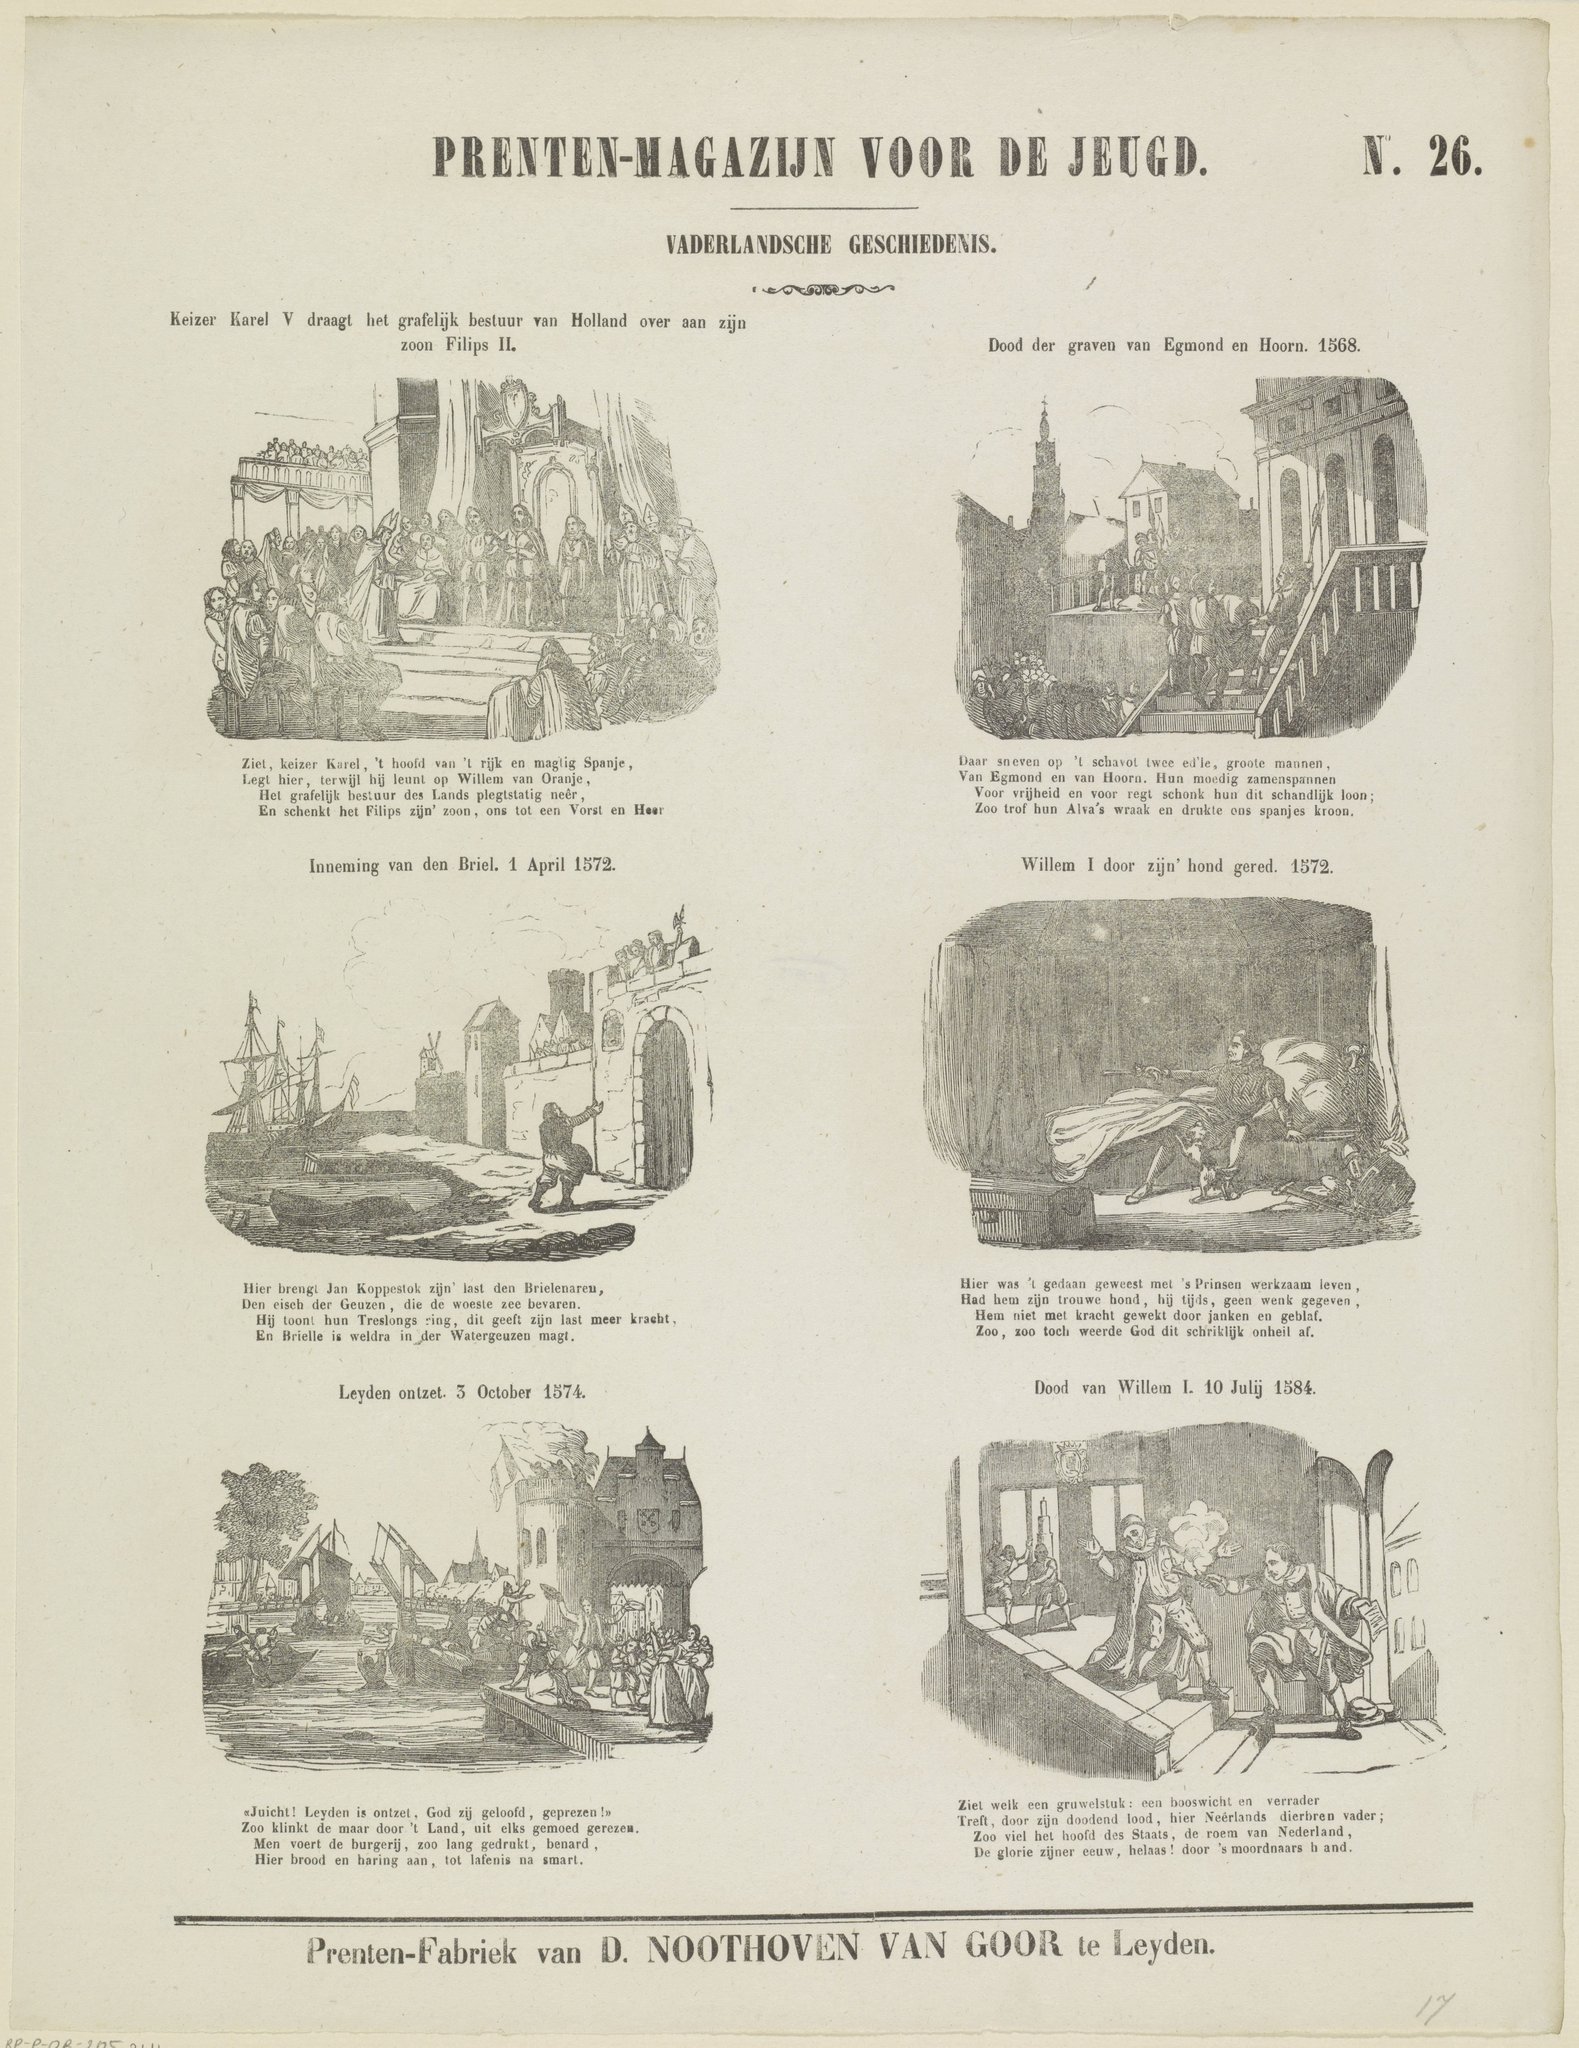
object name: print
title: Vaderlandse geschiedenis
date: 1850-1881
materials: paper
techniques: letterpress printing, engraving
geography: leiden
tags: philip ii of spain, delft, william i (prince of orange), brussels, ghent, charles v (holy roman emperor and king of spain), earl, history, murder, murderer, leiden, brielle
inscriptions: collector's mark: Lugt 2228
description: Blad met 6 voorstellingen van gebeurtenissen uit de vaderlandse geschiedenis, ten tijde van Willem I. Boven elke voorstelling een titel en onder elke voorstelling een vierregelig vers. Genummerd rechtsboven: No. 26.